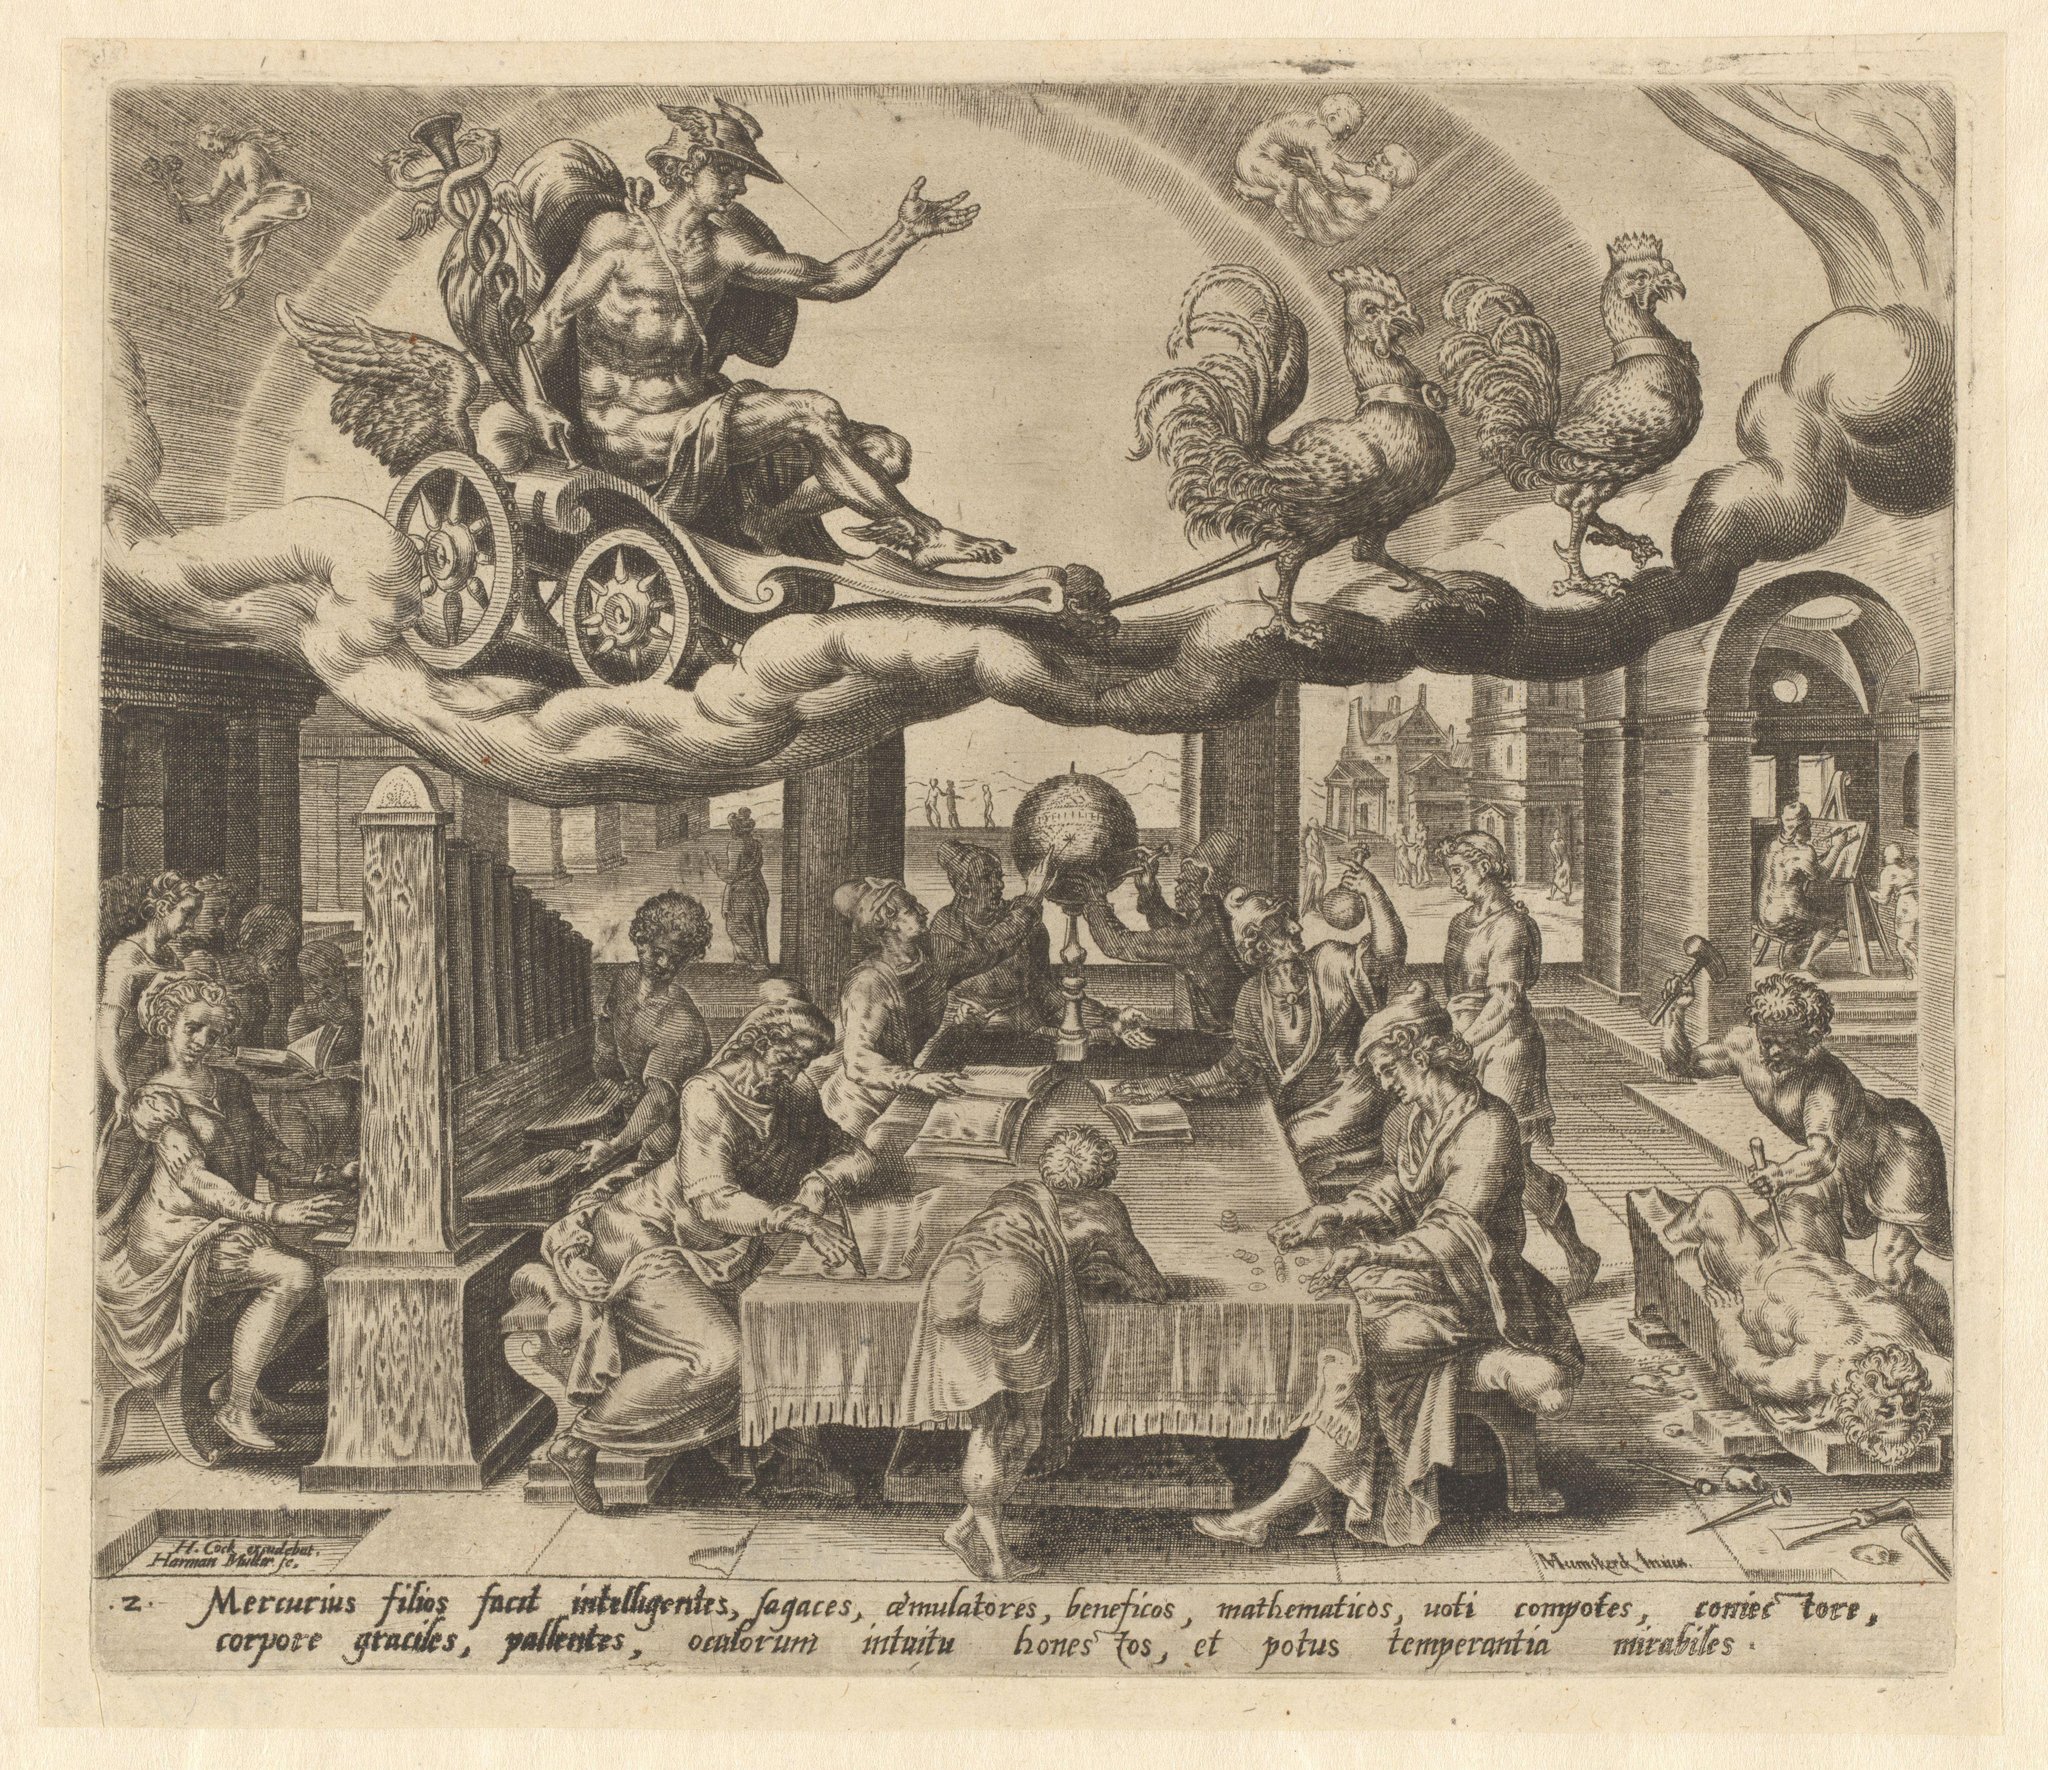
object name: print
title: De planeet Mercurius en zijn kinderen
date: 1566-1570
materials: paper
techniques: engraving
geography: antwerp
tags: sculptor at work, mercury and his children ('planetenkinder') ~ gemini and virgo, organ, astrologer at work, painter at work, in his studio, fowl (cock, hen, chicken, etc.)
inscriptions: collector's mark: Lugt 2228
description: Mercurius rijdt in zijn wagen aan de hemel, getrokken door twee hanen. De tekens van Maagd en Tweeling geven aan welke mensen tot de invloedssfeer van Mercurius behoren. De mensen, die onder dit sterrenbeeld geboren zijn, zijn geleerd en kunstzinnig. Rond een tafel zitten wetenschappers, astrologen, een handelaar en een dokter. Links maken mensen muziek bij een orgel. Rechts zijn een beeldhouwer en schilder aan het werk. Onderaan in de marge een tekst in het Latijn over de kinderen van Mercurius.